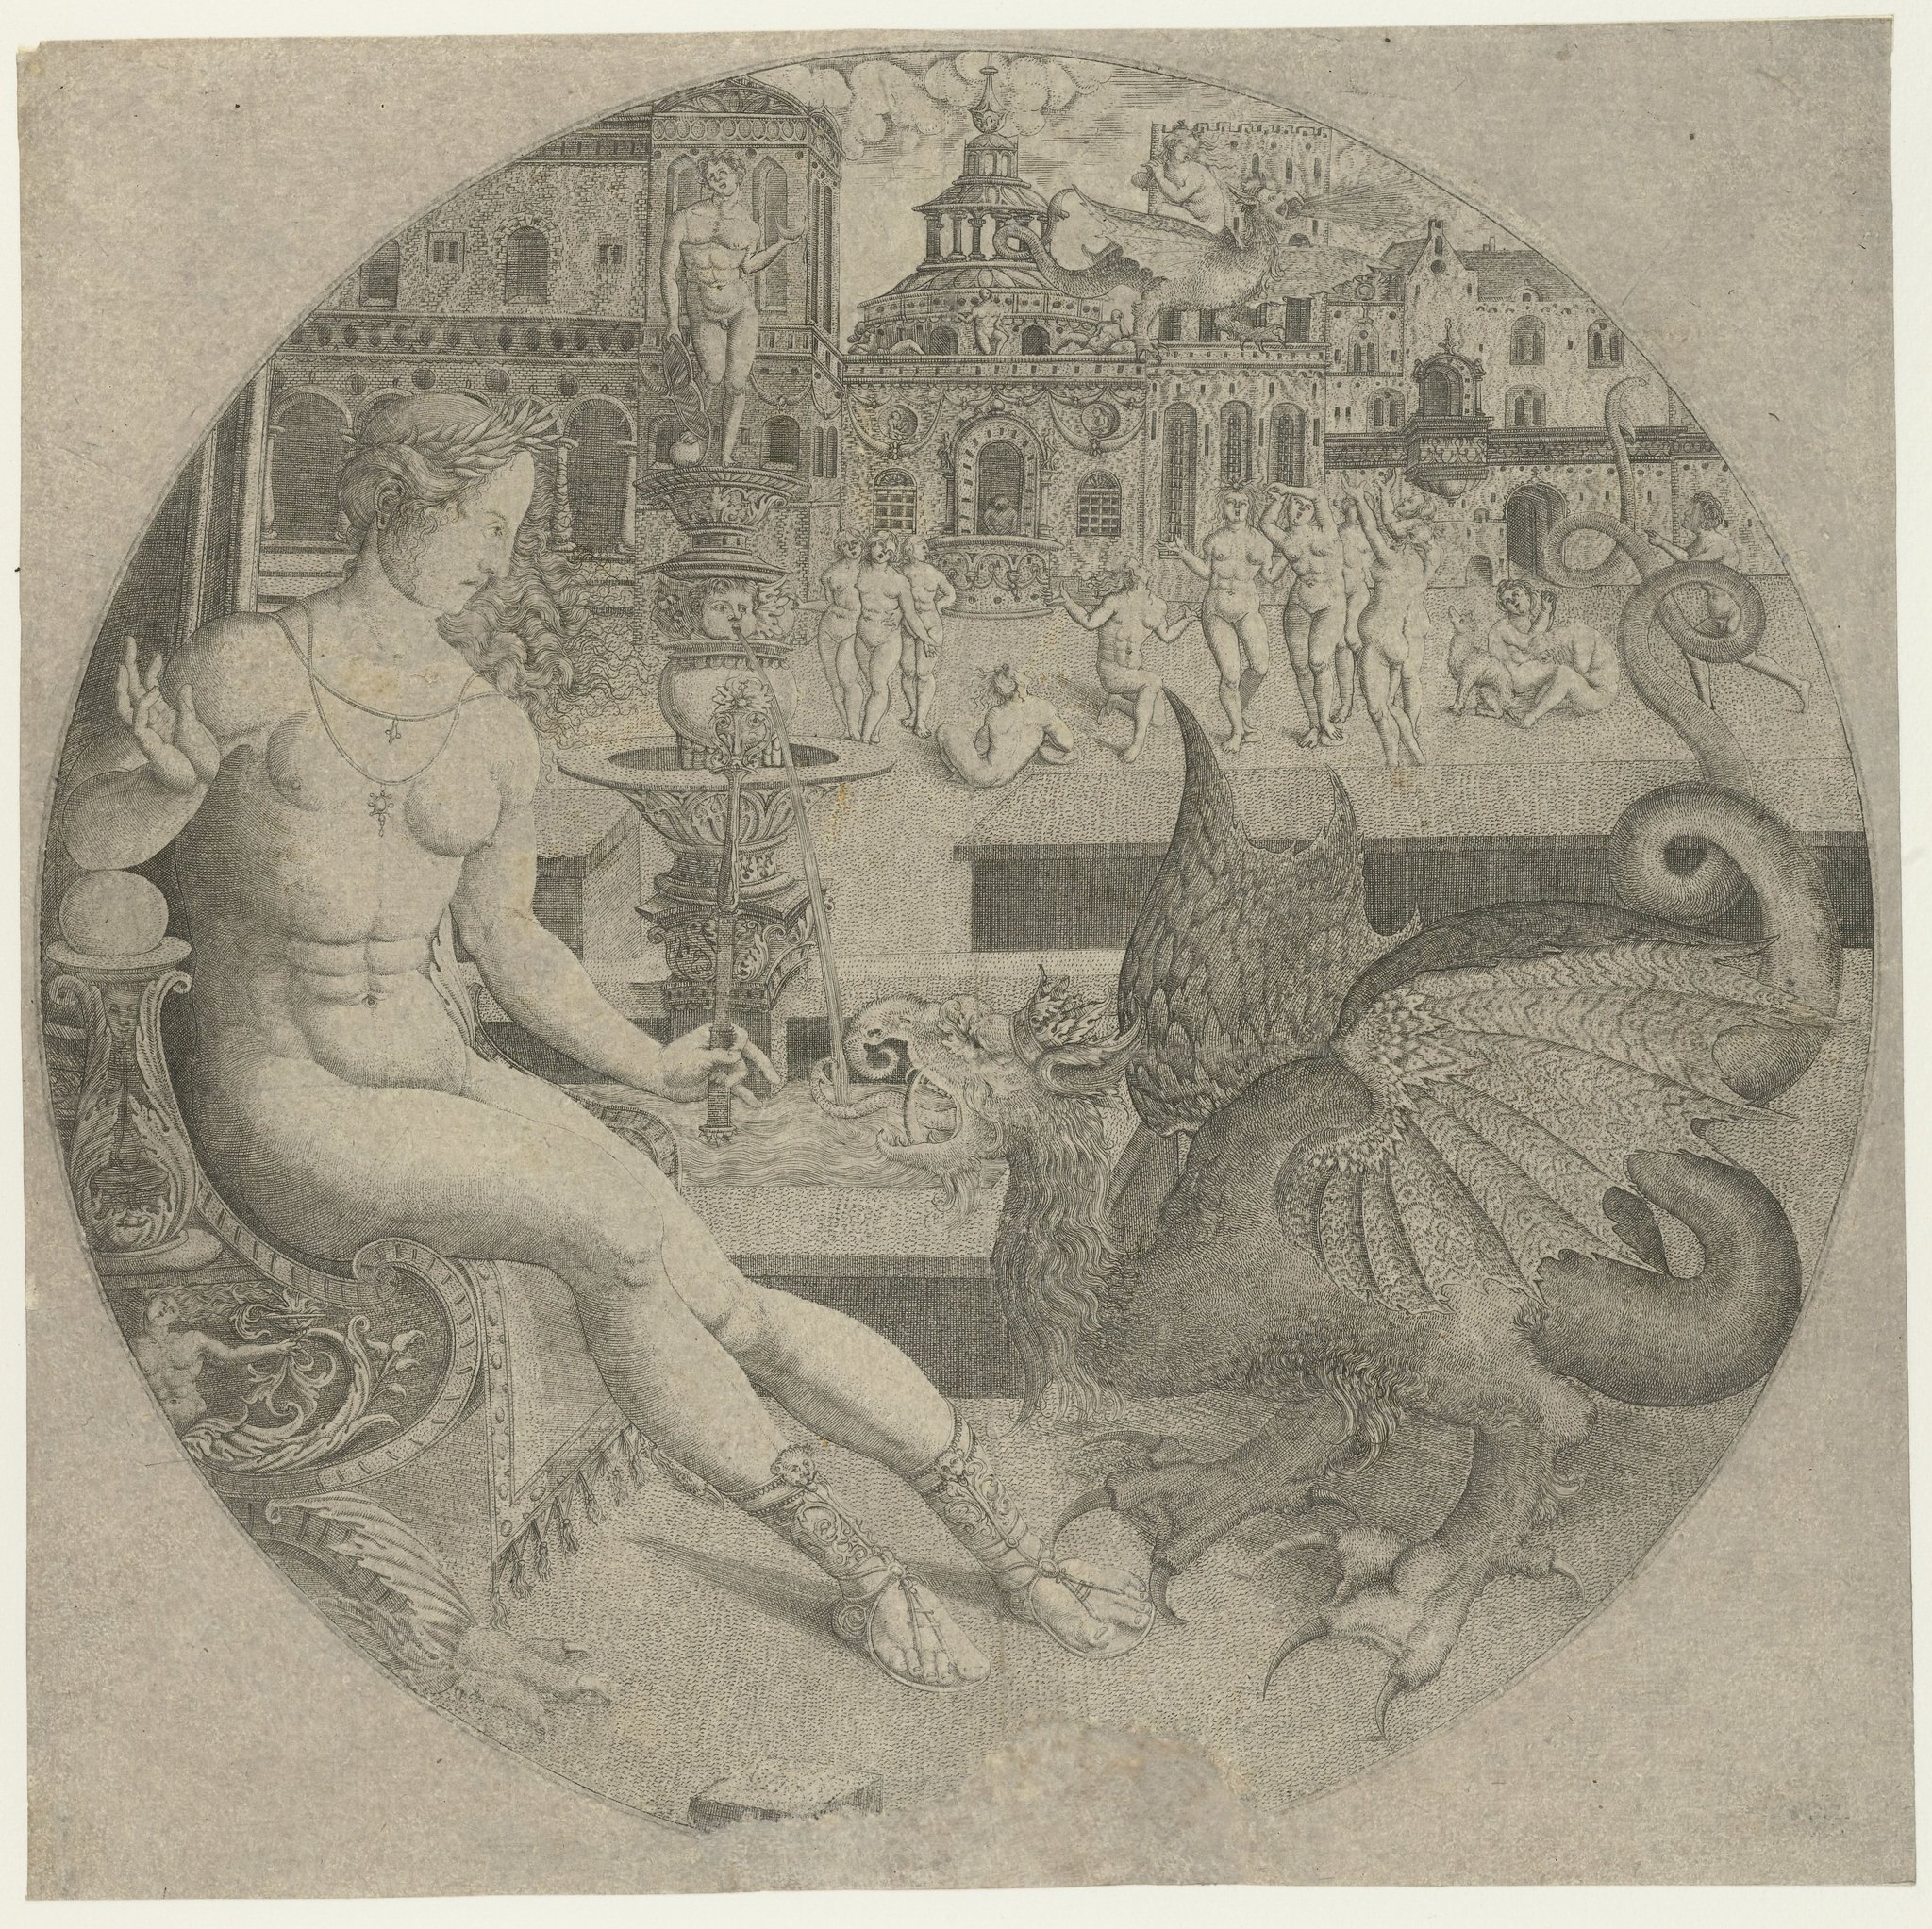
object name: print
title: Heilige Martha en de draak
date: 1553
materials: paper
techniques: engraving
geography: low countries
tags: 11h(martha)51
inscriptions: collector's mark: Lugt 234, collector's mark: Lugt 2529, collector's mark: Lugt 1606, collector's mark: Lugt 2922, collector's mark: Lugt 2228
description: Twee scènes uit verhaal van Martha en de draak. Op de voorgrond: Martha met staf en lauwerkrans op troon, tegenover haar tamme draak. Op de achtergrond: stadsplein met naakte vrouwen en Martha op draak vliegend boven plein.